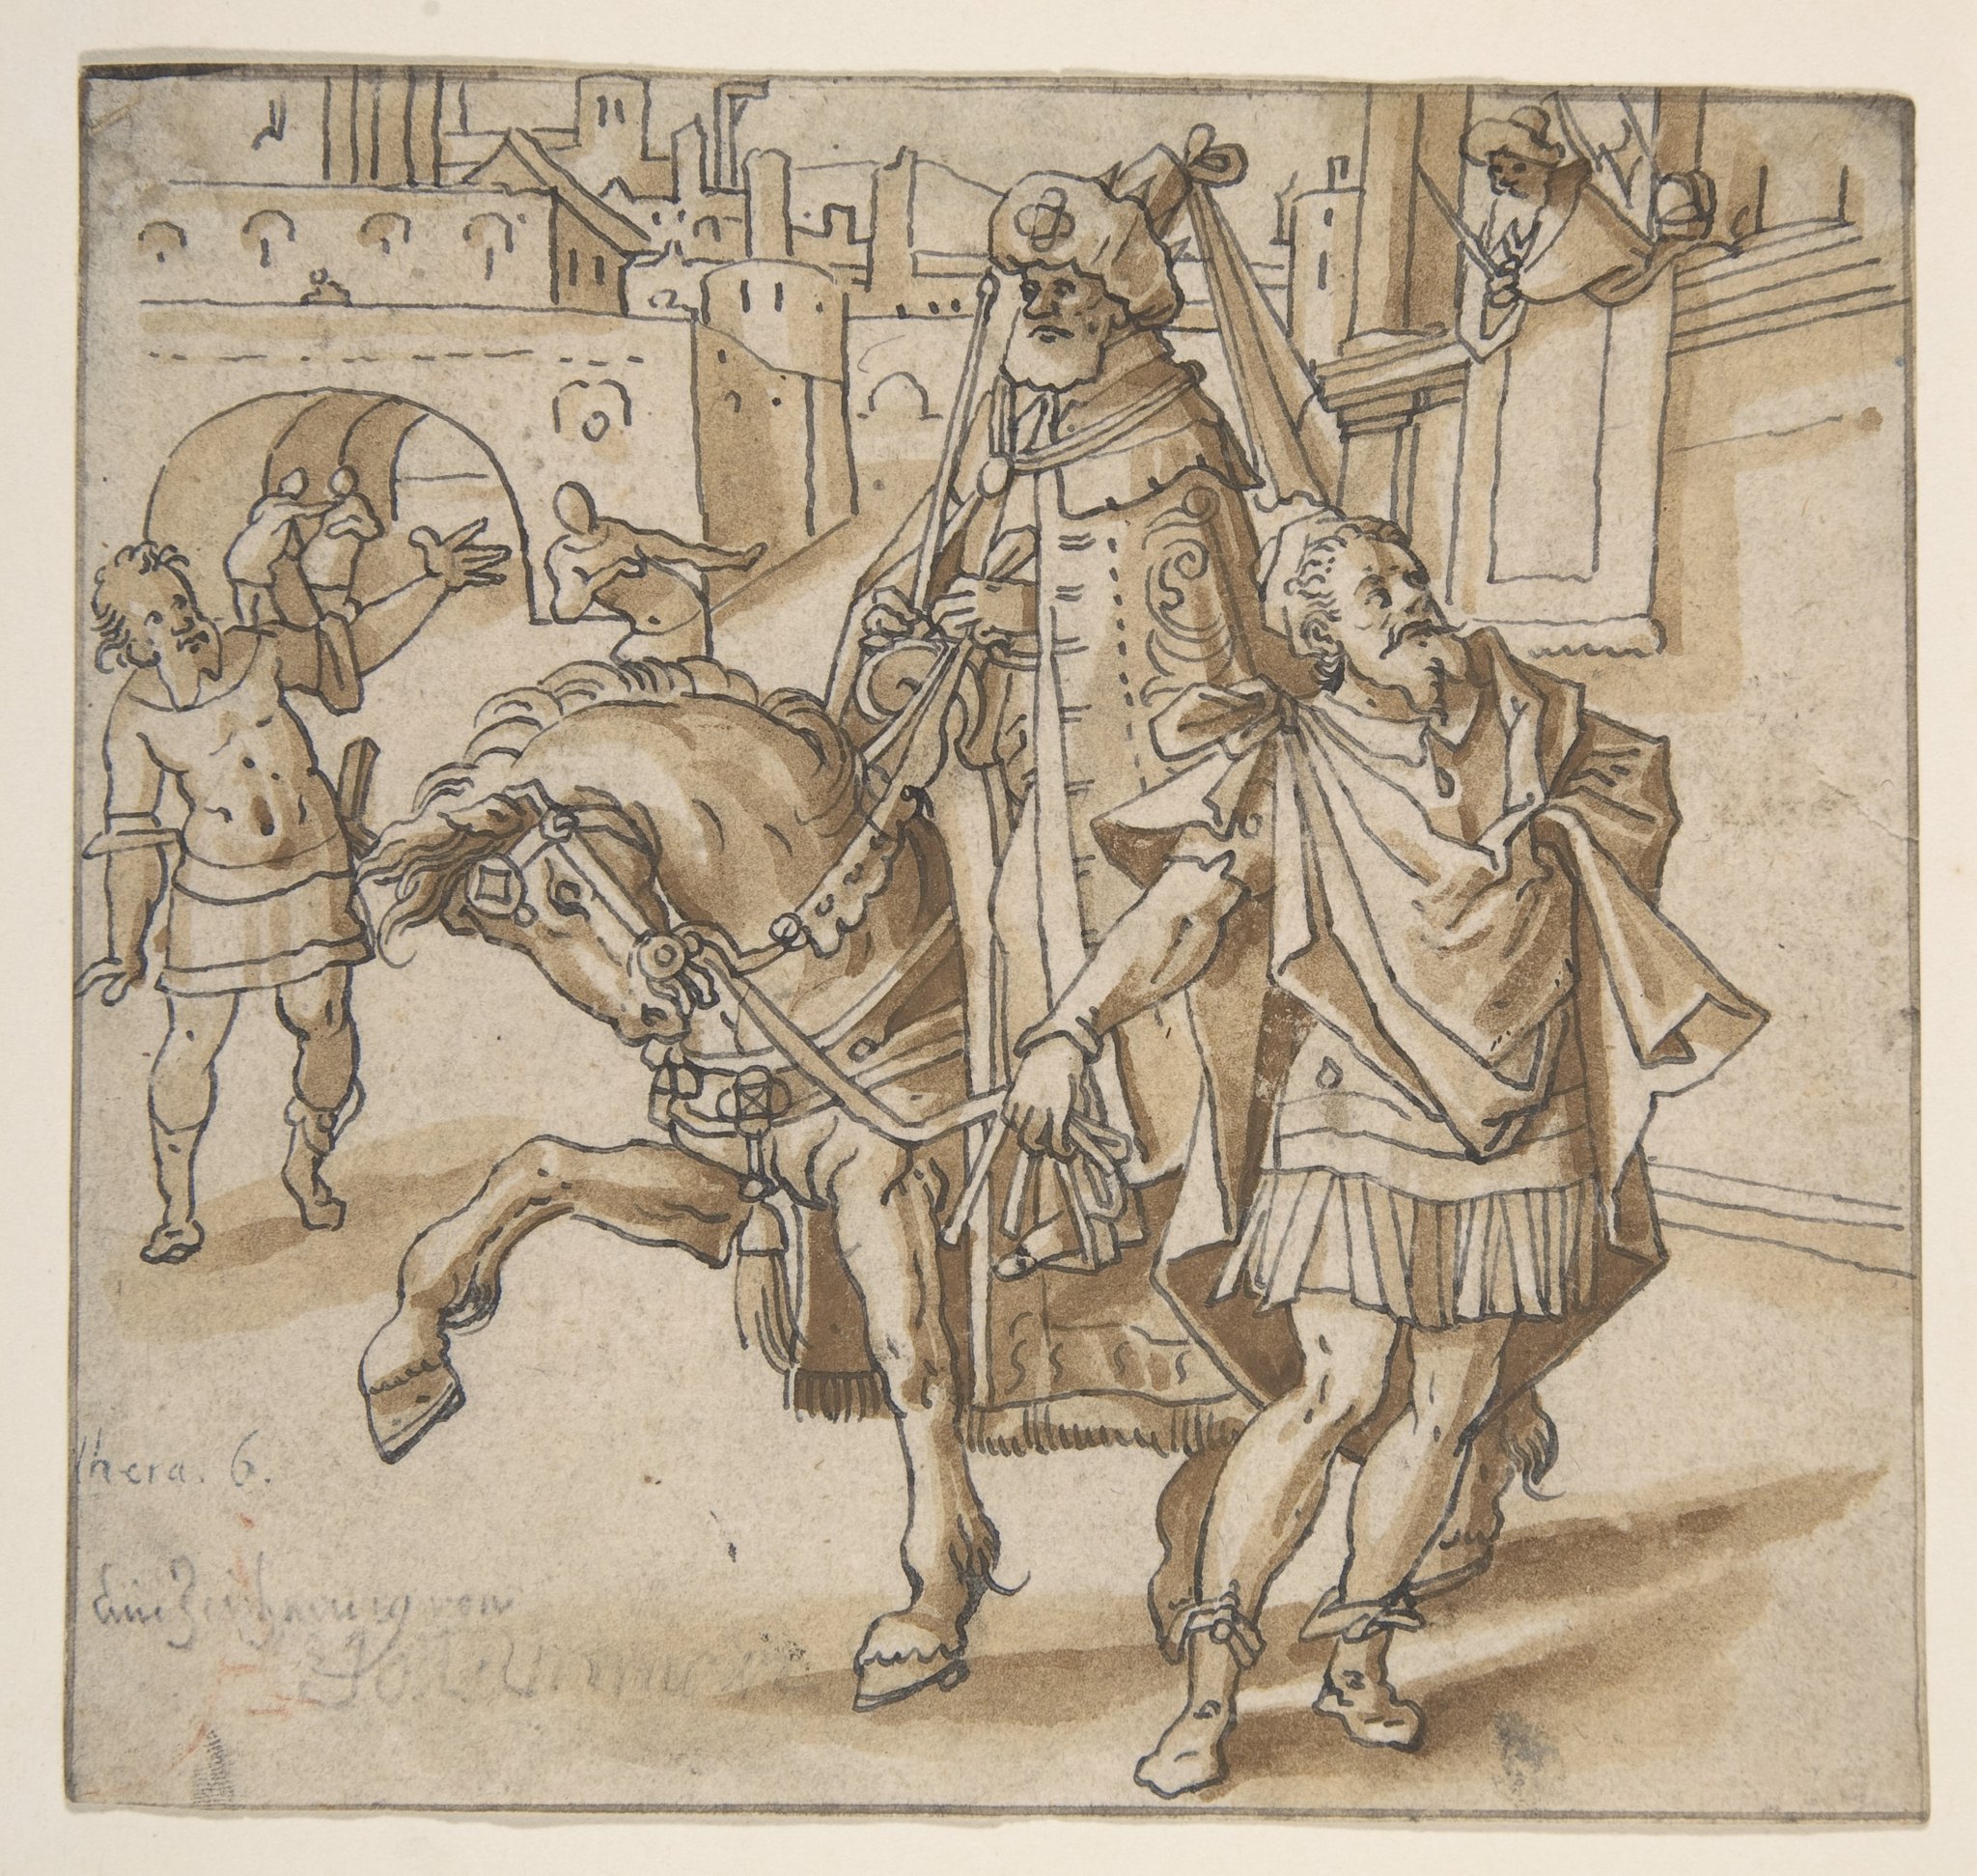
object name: drawing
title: Triumph of Mordecai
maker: hans ulrich fisch vom stein i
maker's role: artist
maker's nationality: swiss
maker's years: 1583-1647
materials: ink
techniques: brush, pen, wash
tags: buildings,men,horses